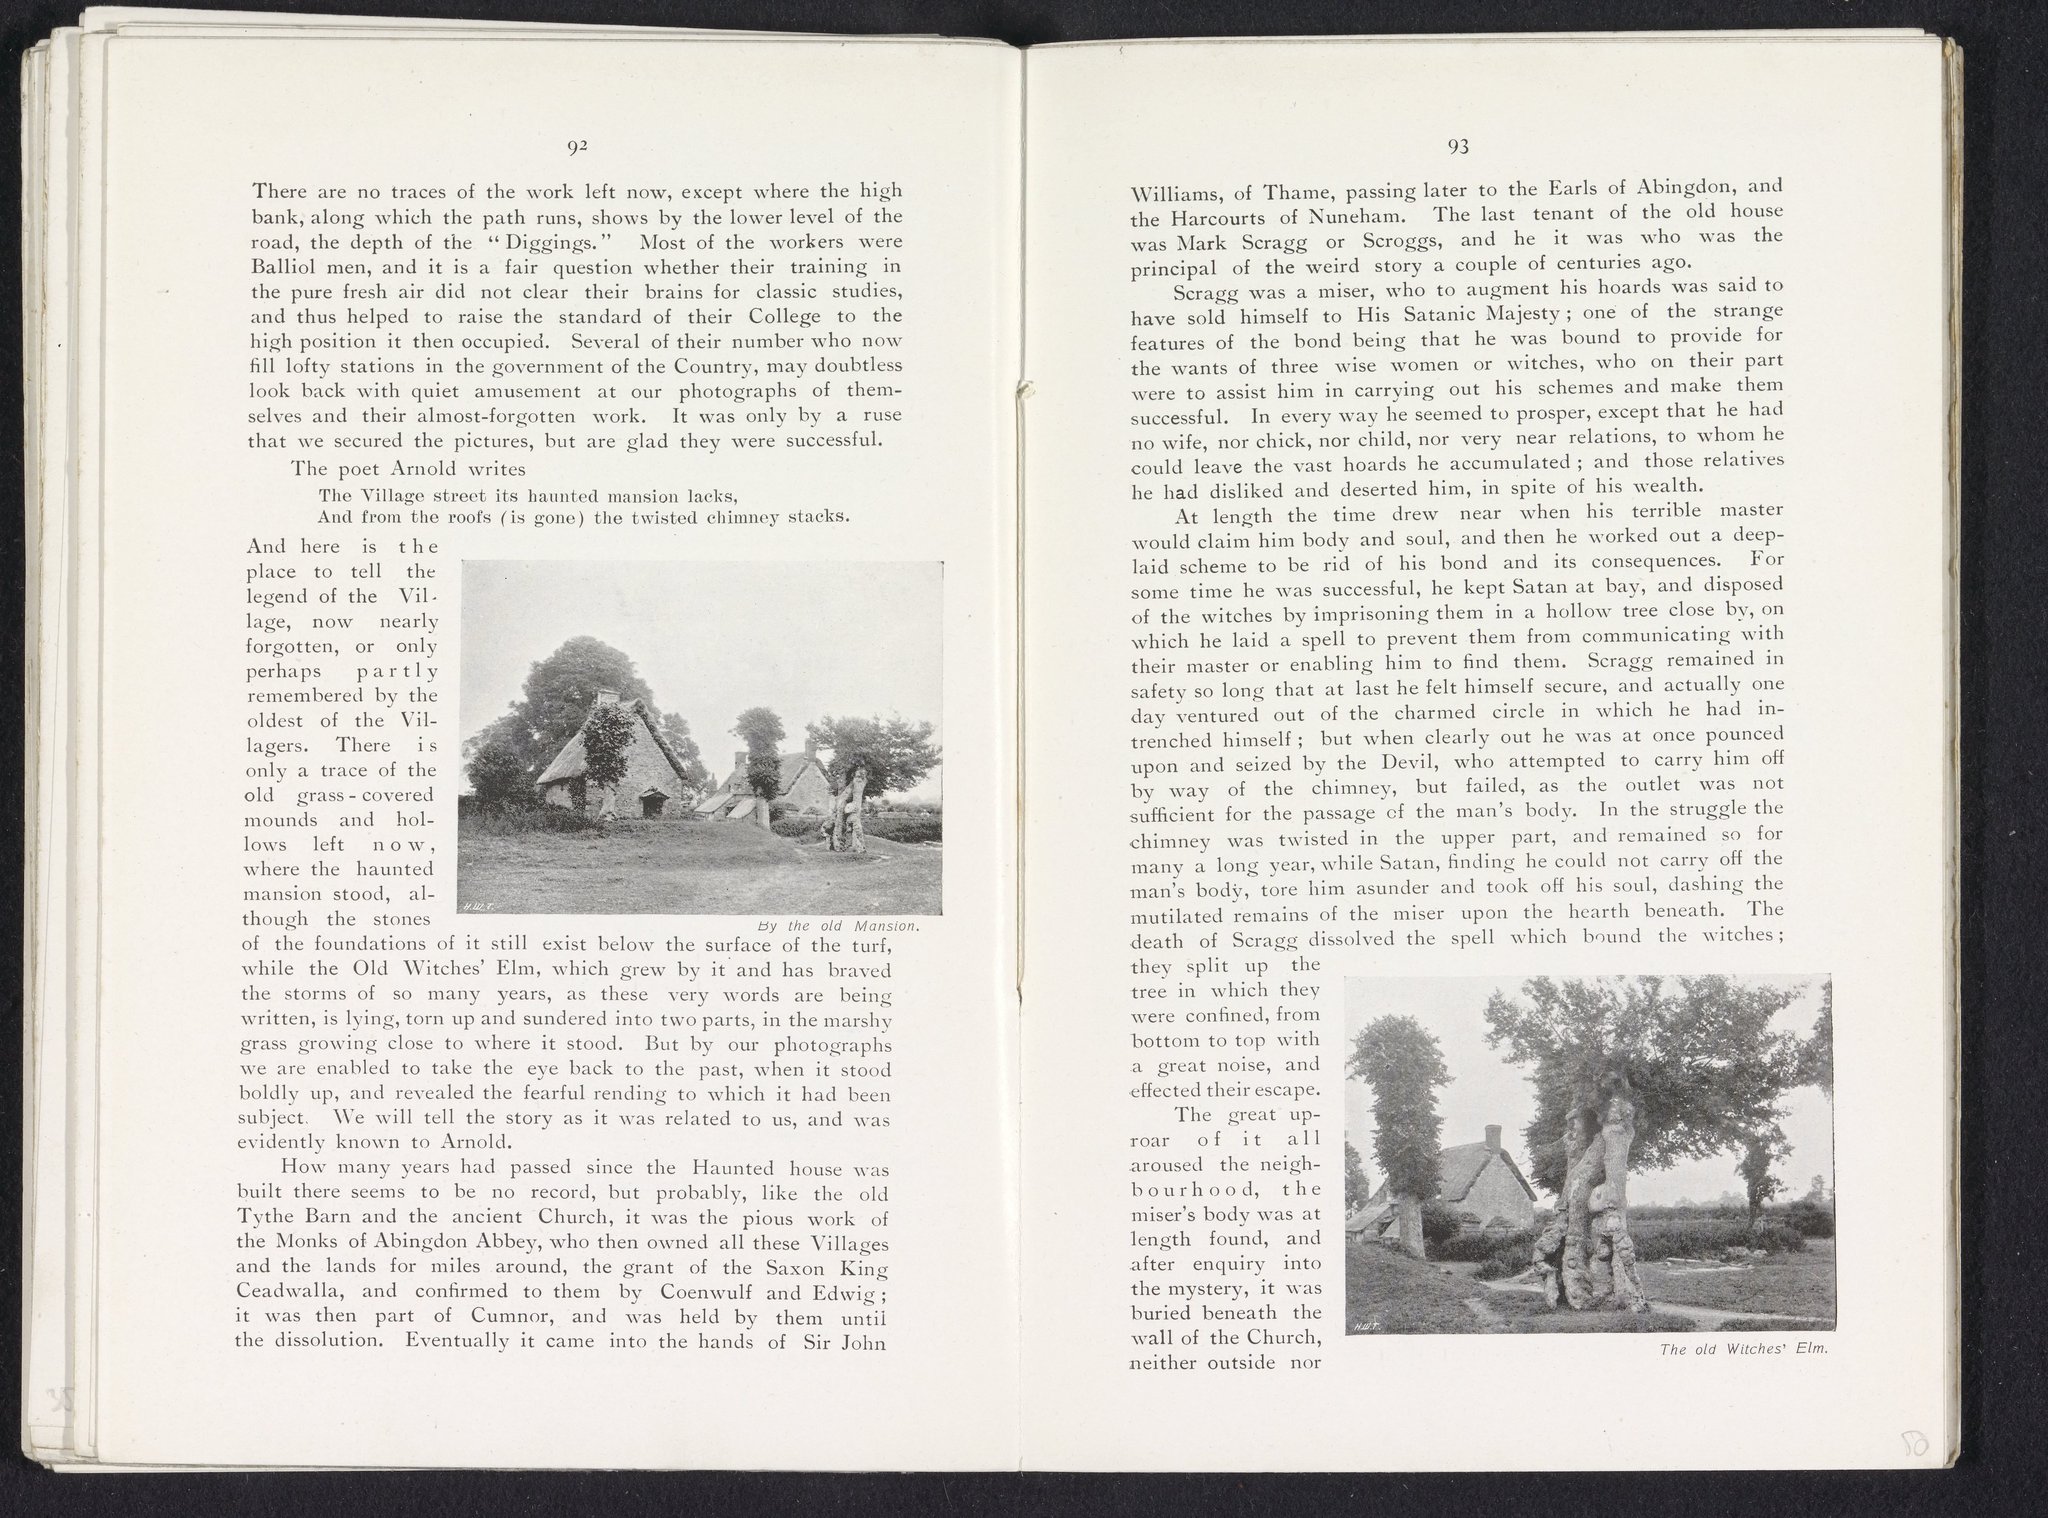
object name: page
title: By the old mansion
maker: henry w. taunt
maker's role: fotograaf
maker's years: 1842-1922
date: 1907-1912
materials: paper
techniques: autotype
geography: north hinksey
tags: housing, façade (of house or building)